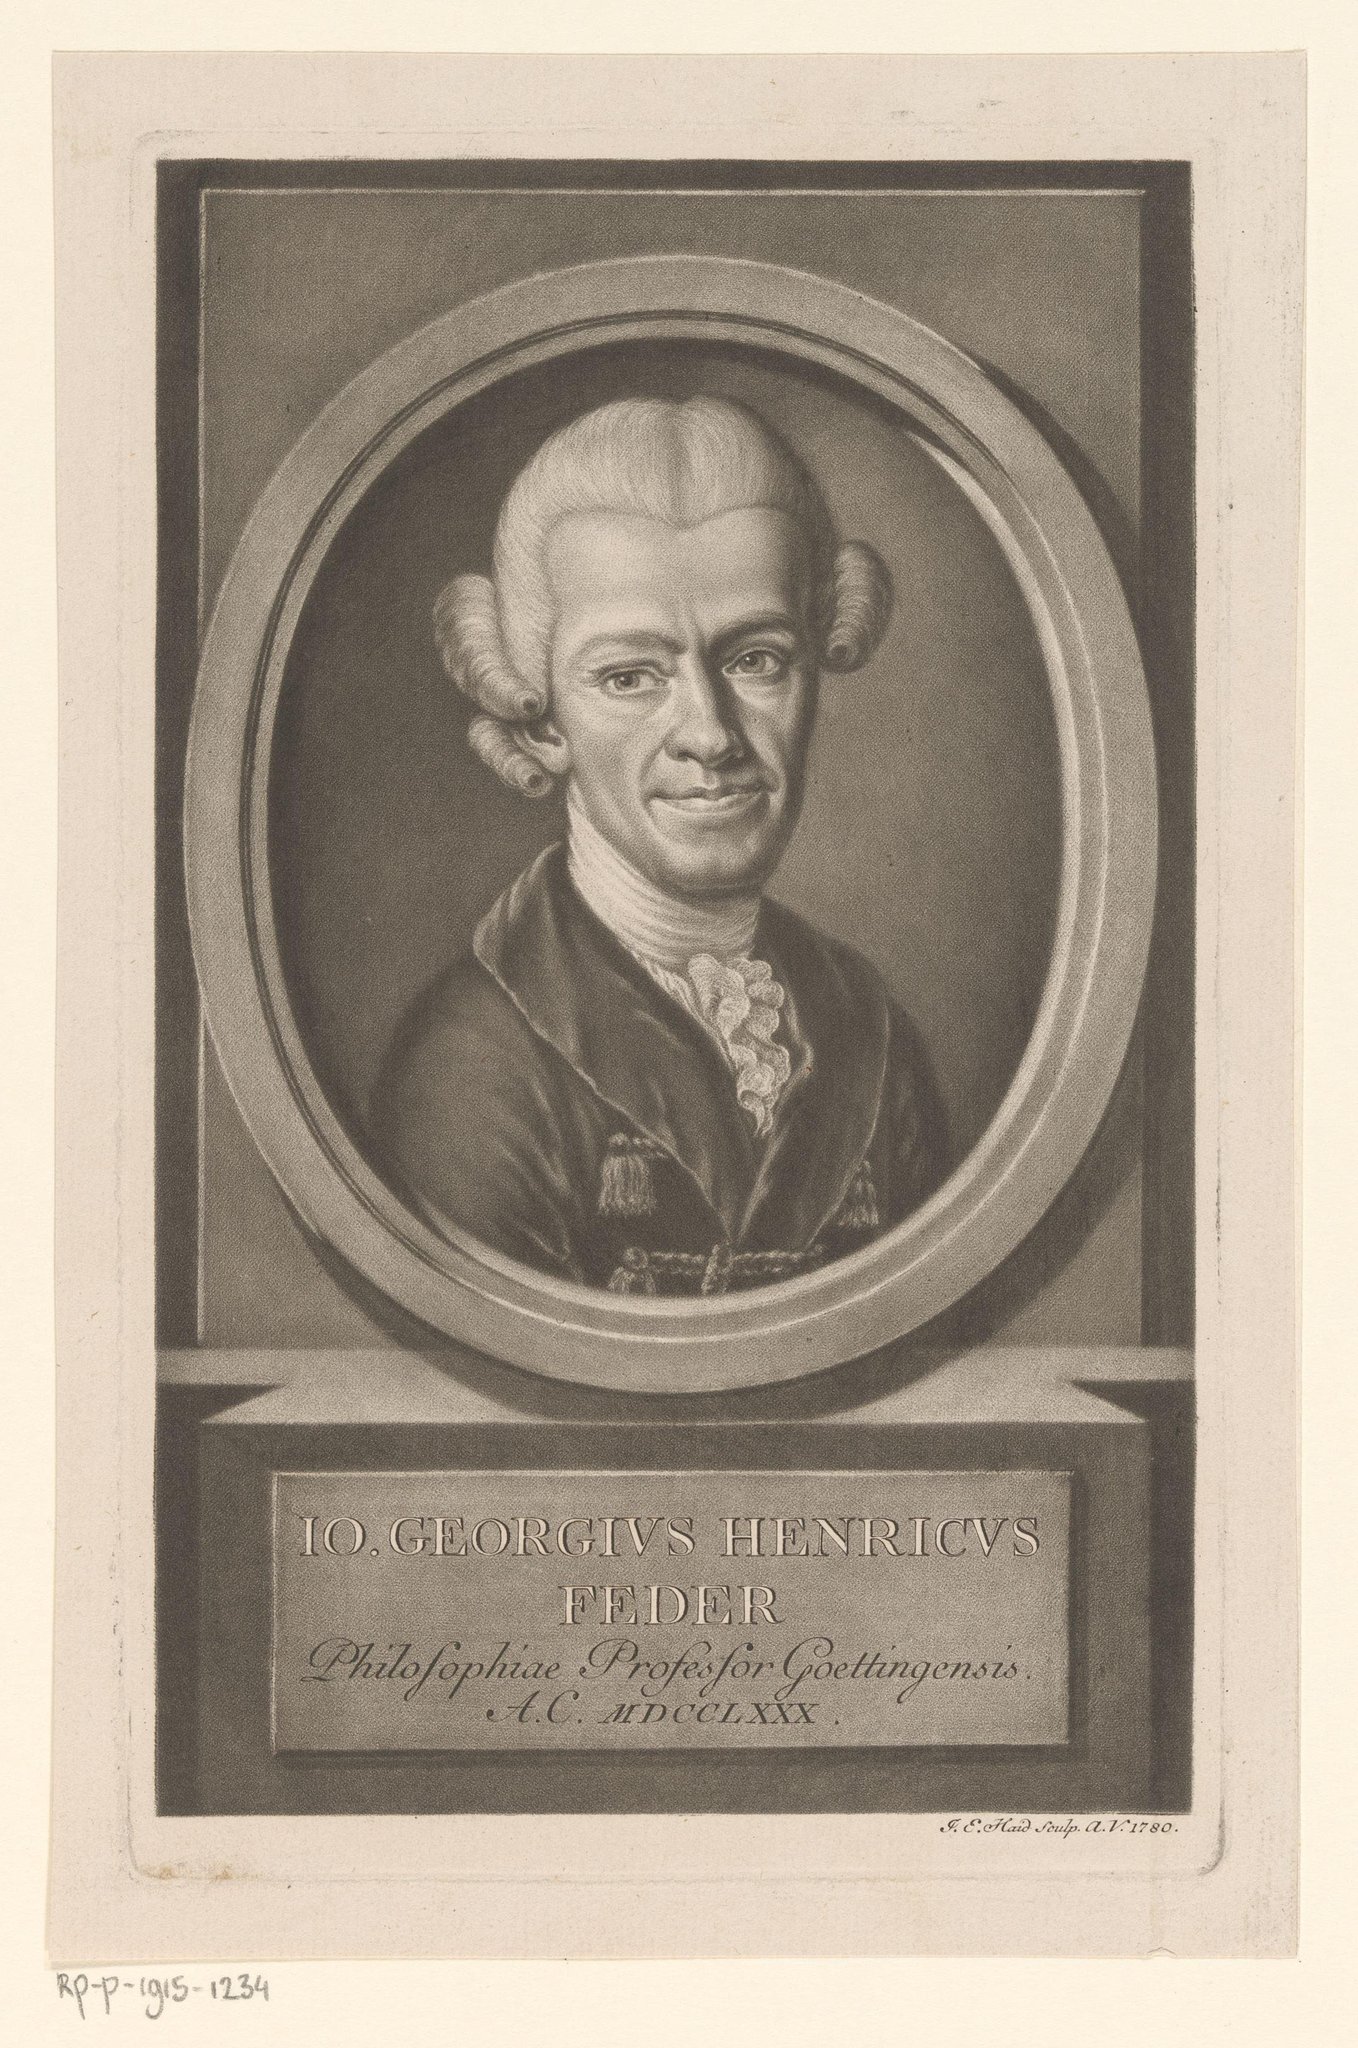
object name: print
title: Portret van Johann Georg Heinrich Feder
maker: johann elias haid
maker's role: print maker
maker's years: 1739-1809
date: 1780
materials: paper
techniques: mezzotint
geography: augsburg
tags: scholar, philosopher, historical persons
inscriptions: collector's mark: Lugt 2228